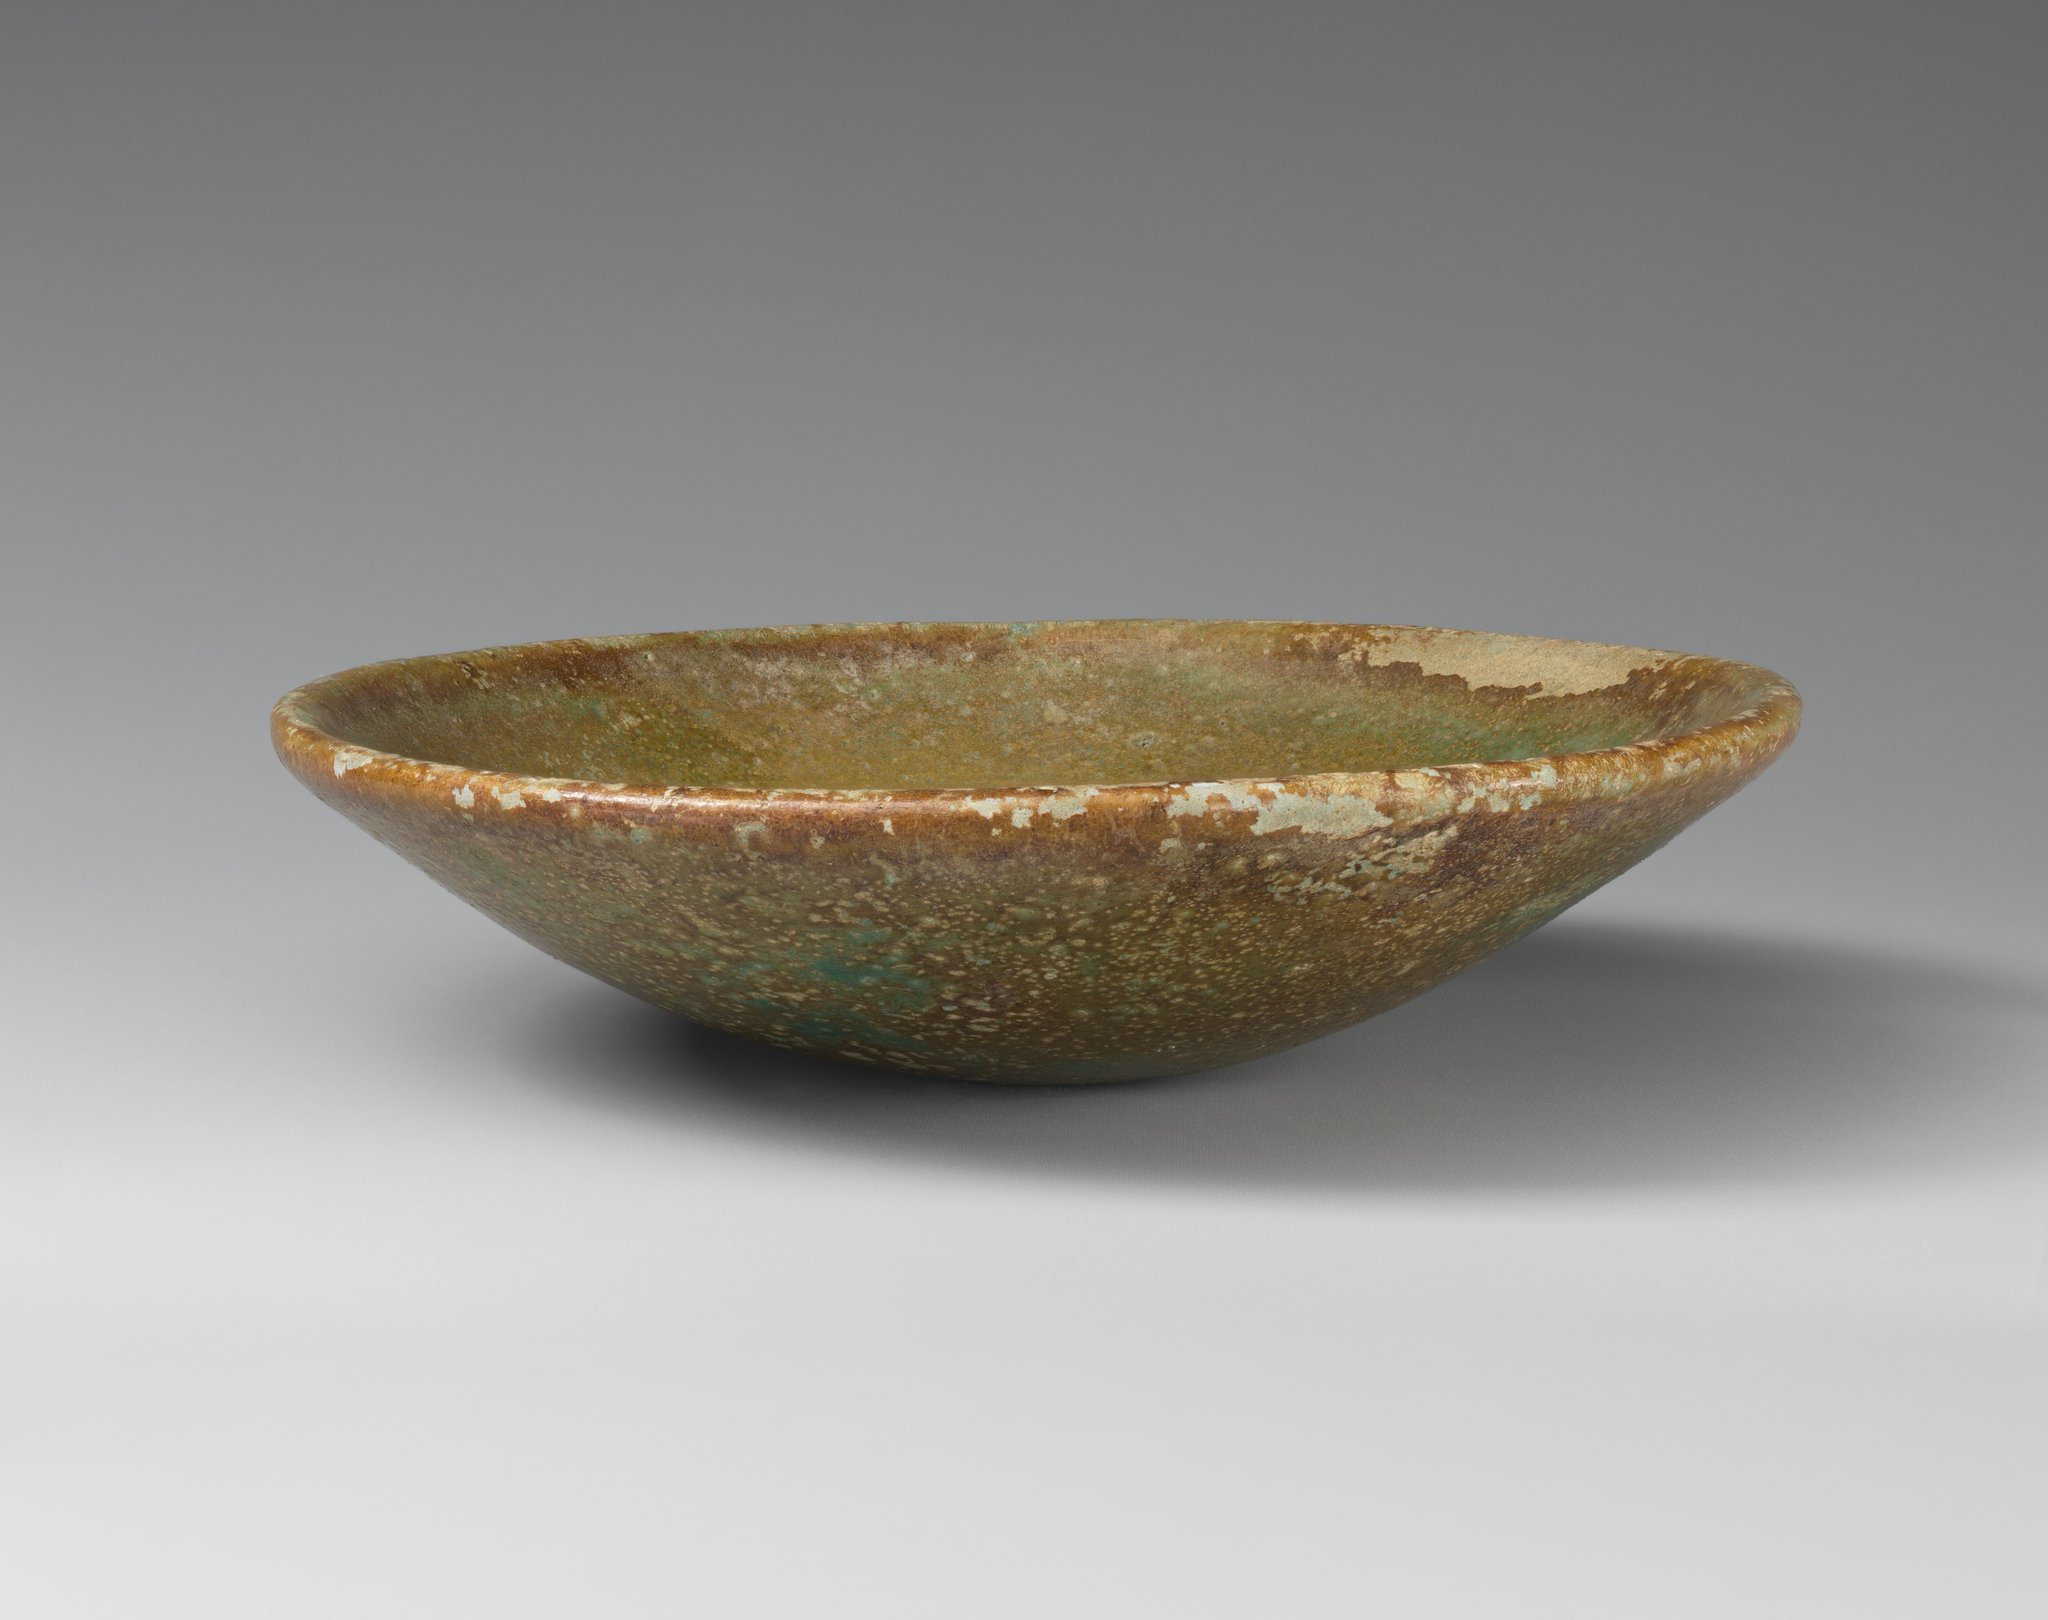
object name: bowl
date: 664-332 BCE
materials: faience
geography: egypt